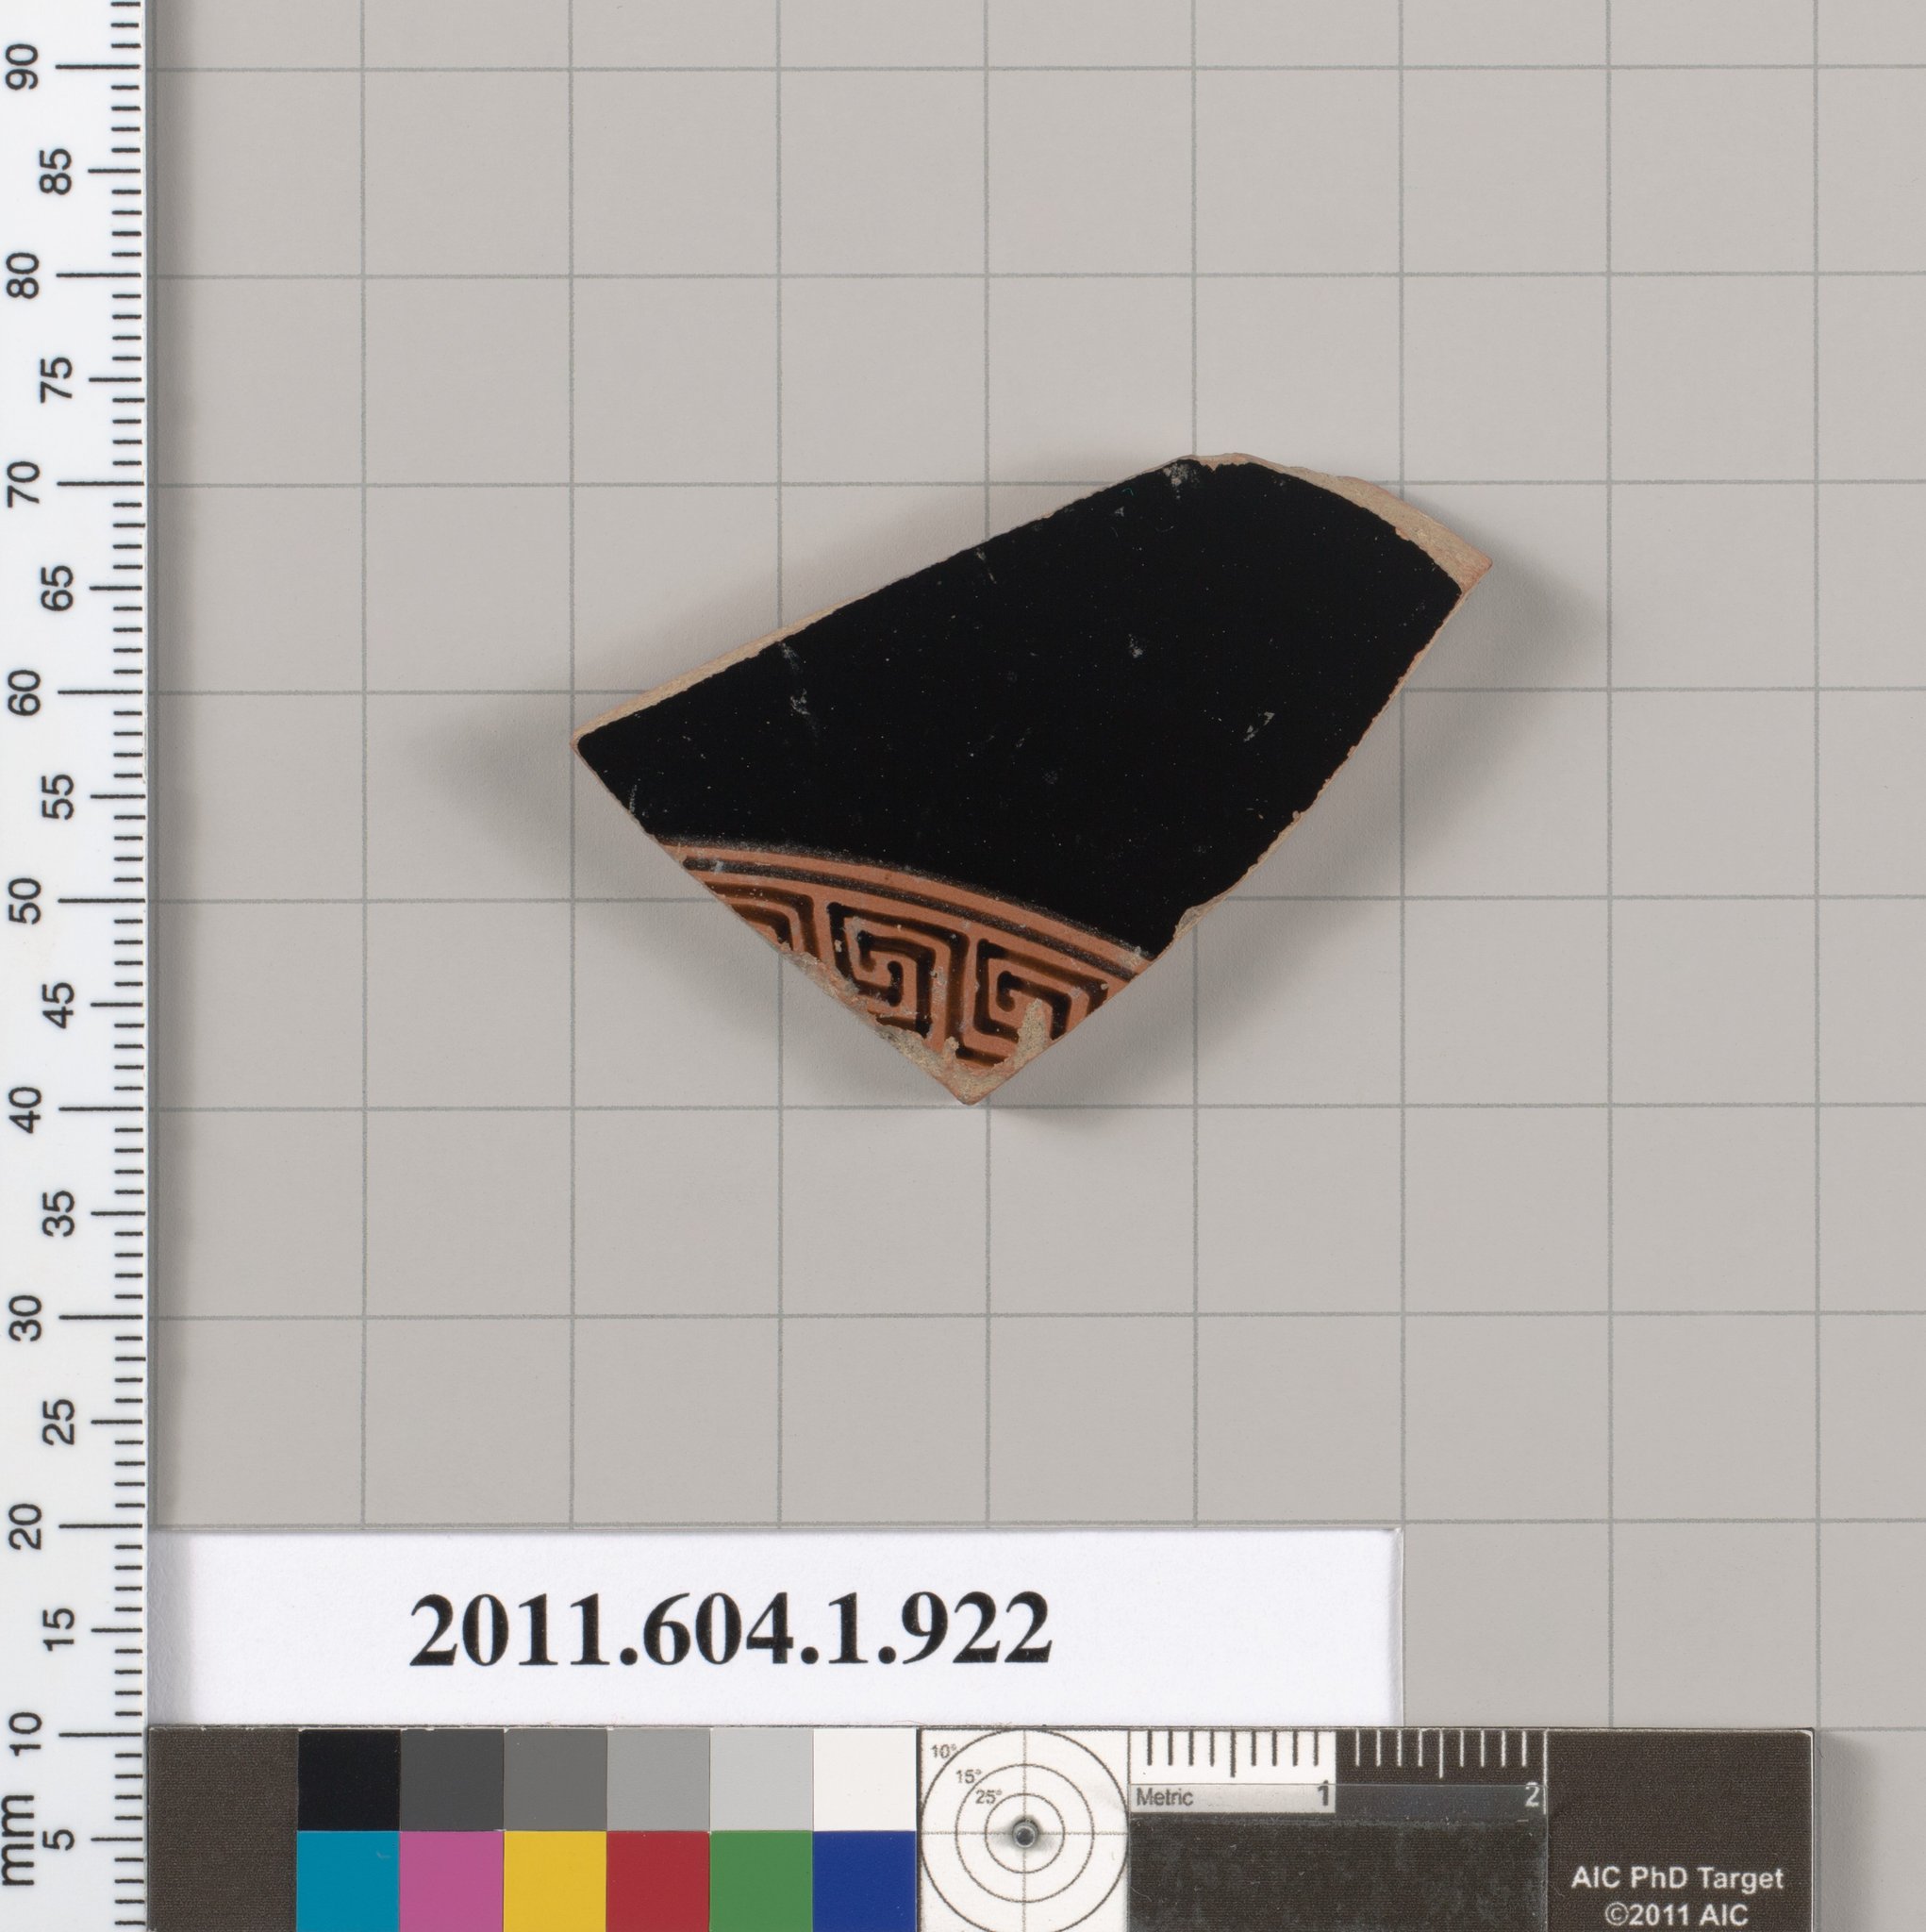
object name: kylix fragment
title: Terracotta fragment of a kylix (drinking cup)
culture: greek, attic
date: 490-480 BCE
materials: terracotta